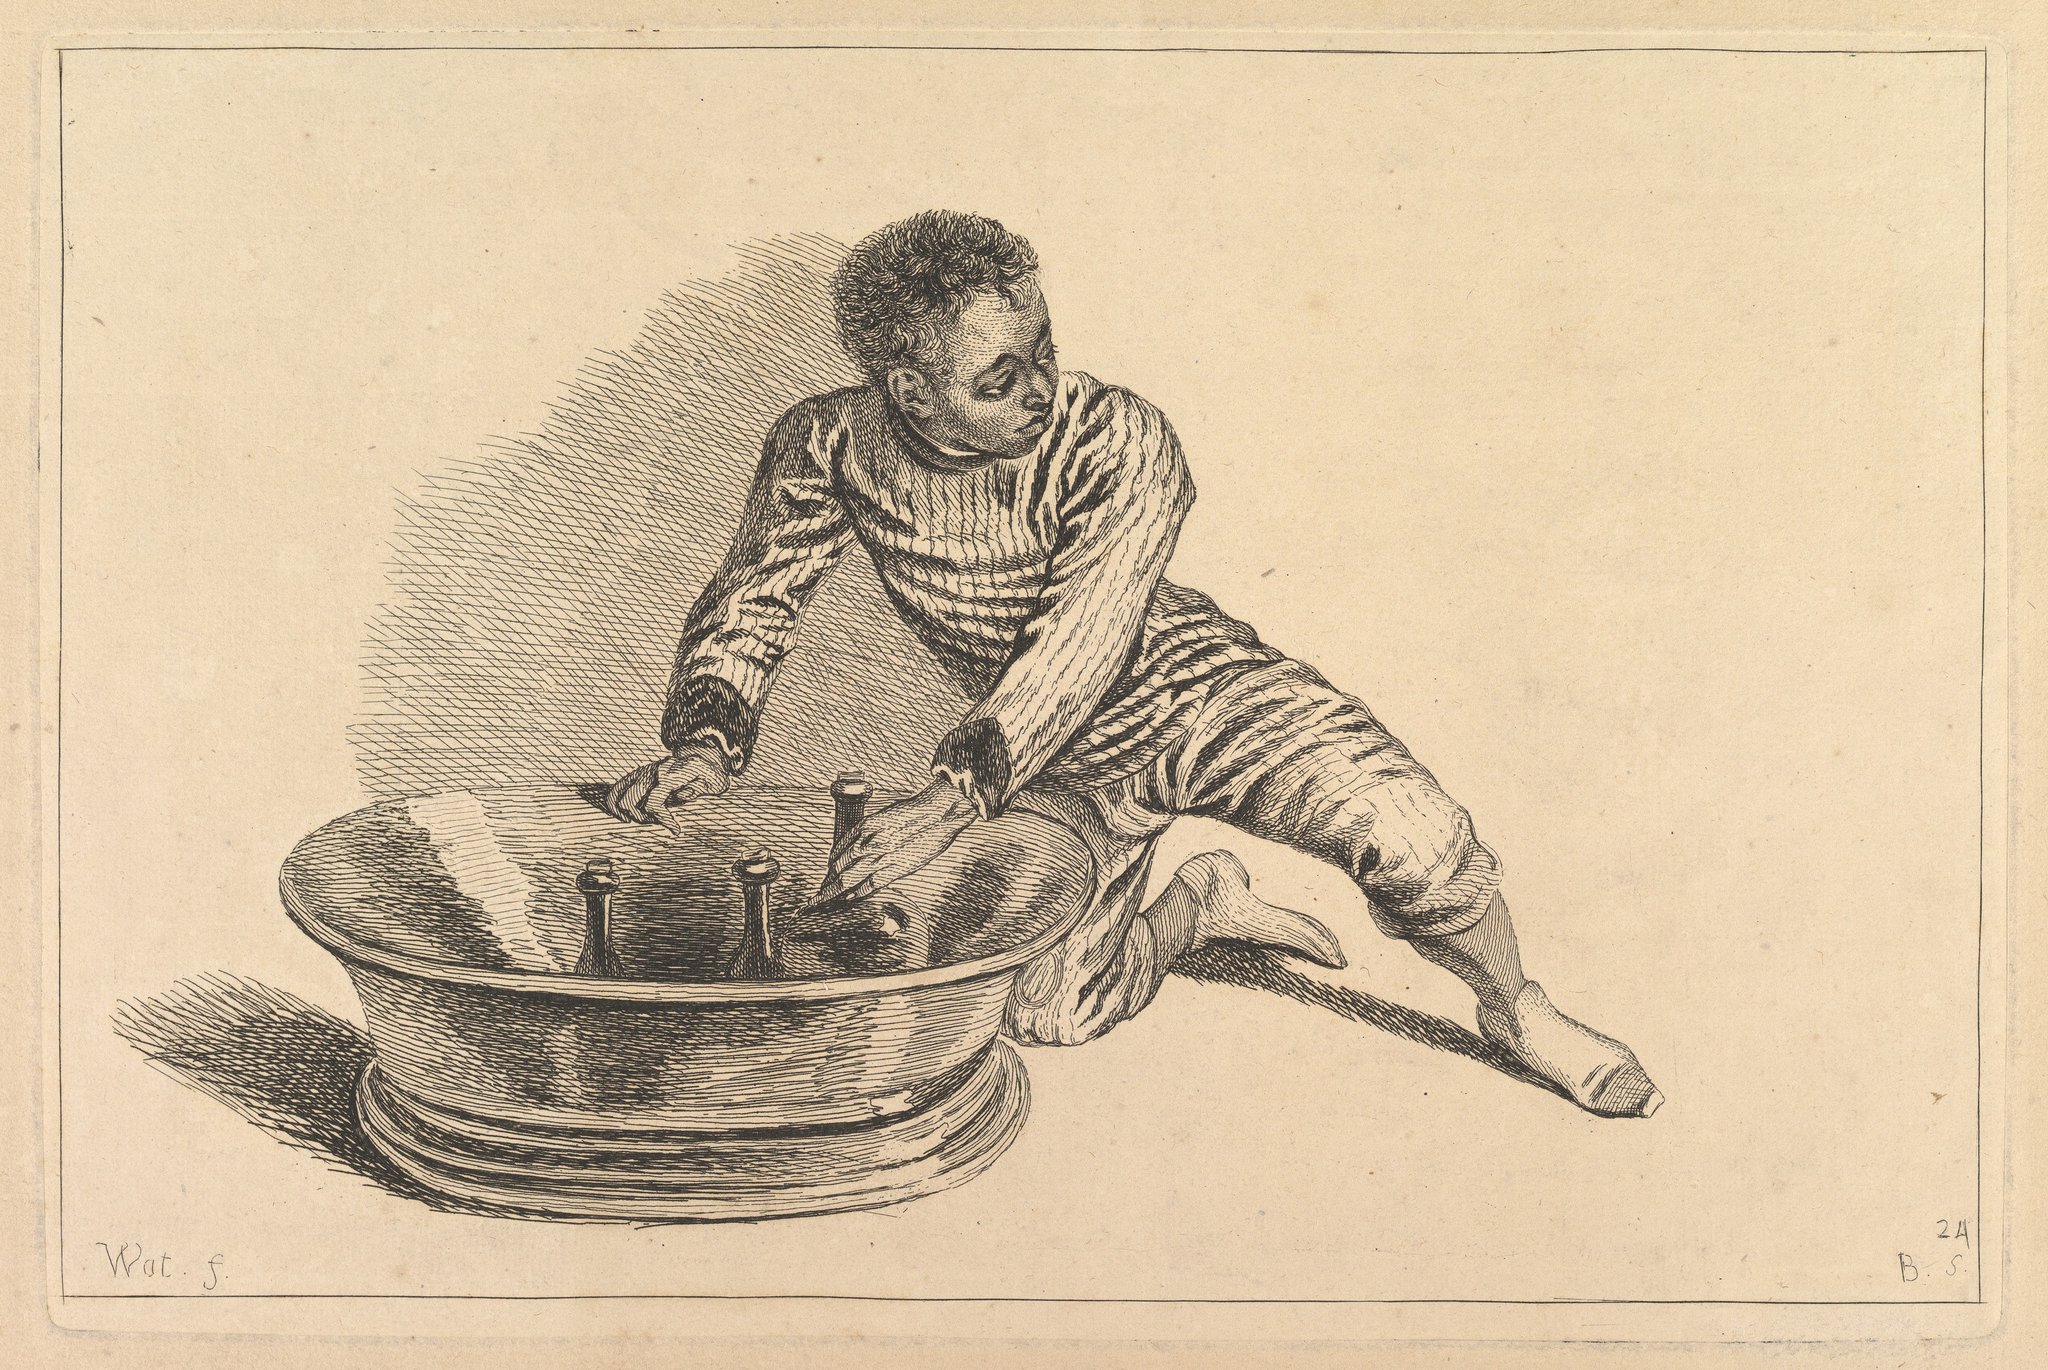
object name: print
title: Black African Removing Bottles From a Cooler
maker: françois boucher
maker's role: artist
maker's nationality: french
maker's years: 1703-1770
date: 1701-1800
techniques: etching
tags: men,bottles